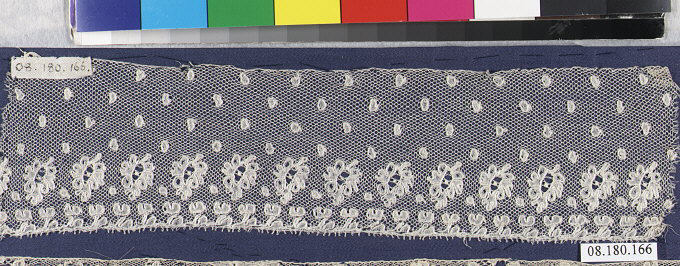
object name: fragment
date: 1701-1900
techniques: lace